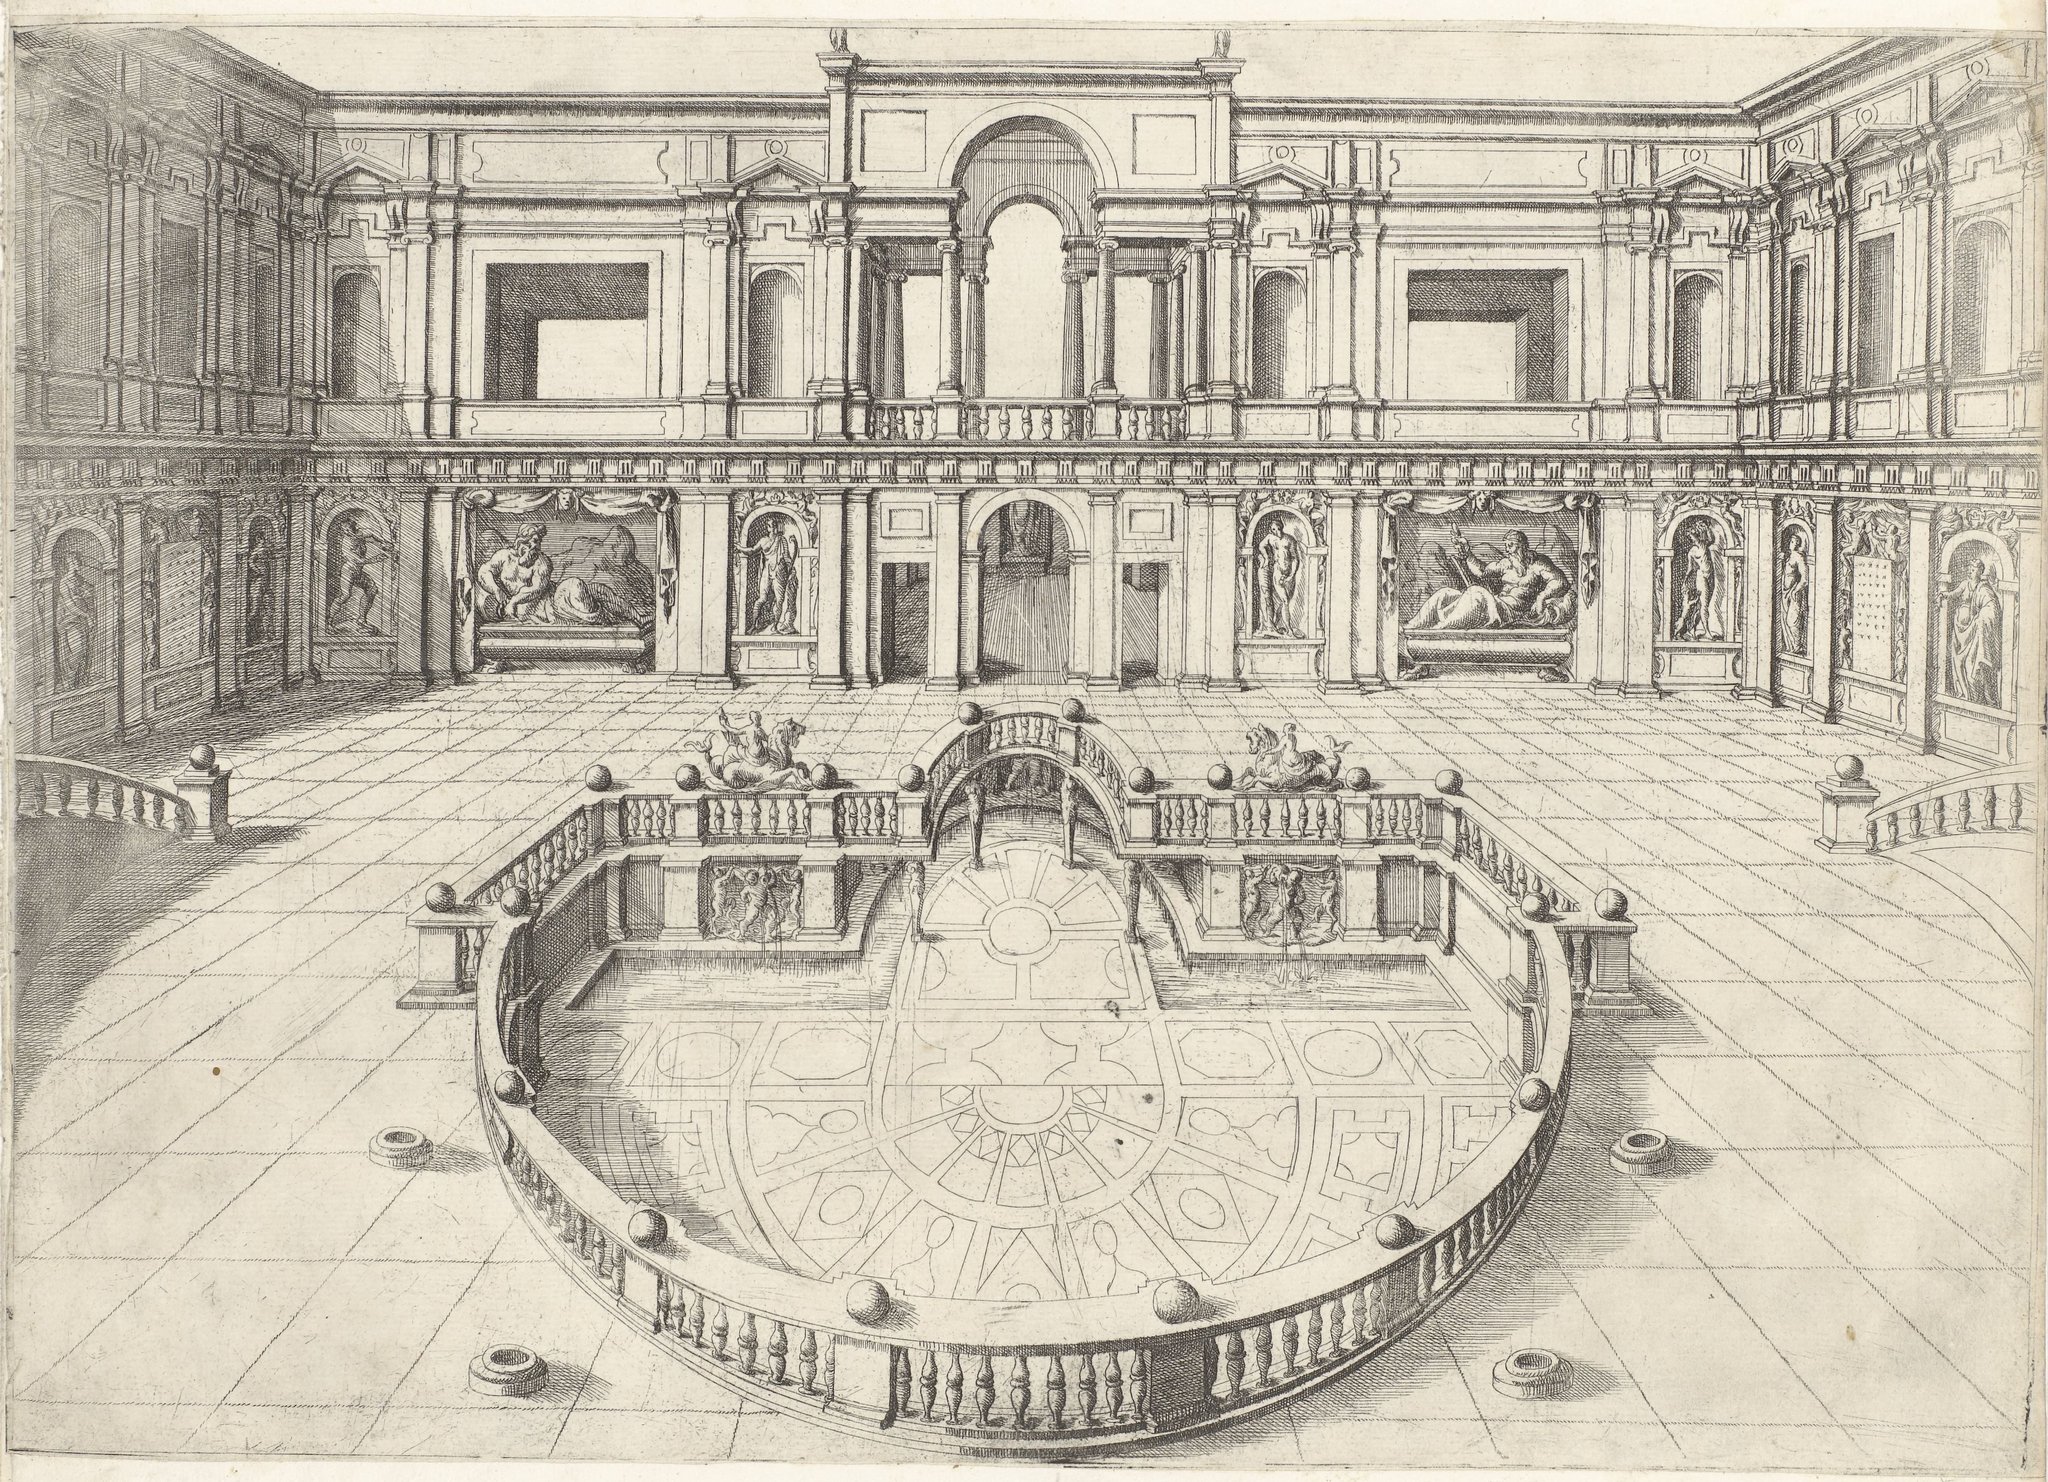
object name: print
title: Binnenhof van de Villa Giulia te Rome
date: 1560-1590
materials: paper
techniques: etching, intaglio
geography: italy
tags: caryatids ~ architecture, courtyard, ornamental fountain, rome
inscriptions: collector's mark: Lugt 2228, collector's mark: Lugt 2760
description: Deze prent is geplakt op een oud albumblad. De prent wordt gerekend tot het supplement op het prentcorpus dat bekend staat als de ‘Speculum Romanae Magnificentiae’ (‘Spiegel van Romeinse pracht’). Dit corpus, bestaande uit prenten met voorstellingen van kunstwerken en gebouwen uit het antieke en het moderne Rome, vond zijn oorsprong bij uitgevers Antonio Salamanca en Antonio Lafreri. Deze twee buitenlandse uitgevers bundelden hun krachten te Rome in de periode 1553-1563. Hun prenten werden al snel razend populair bij toeristen en verzamelaars, die de prenten individueel of in grote groepen aanschaften. Grote groepen Speculum-prenten werden vaak op aanvraag samengebonden in albums. Er zijn verschillende Speculum-albums overgeleverd die allemaal verschillen van inhoud. Tussen 1573 en 1577 gaf Antonio Lafreri een speciale titelpagina uit (met de titel ‘Speculum Romanae Magnificentiae’) die mensen voor hun verzamelingen konden voegen. Het overlijden van Lafreri in 1577 betekende niet het einde van het corpus. Een groot deel van de koperplaten ging over op Claudio en Stefano Duchetti. De rest raakte verspreid over verschillende andere uitgevers. De populariteit van de Speculum-prenten wist nog geruime periode uitgevers te inspireren tot het laten maken van kopieën en het toevoegen van nieuwe prenten aan het corpus.